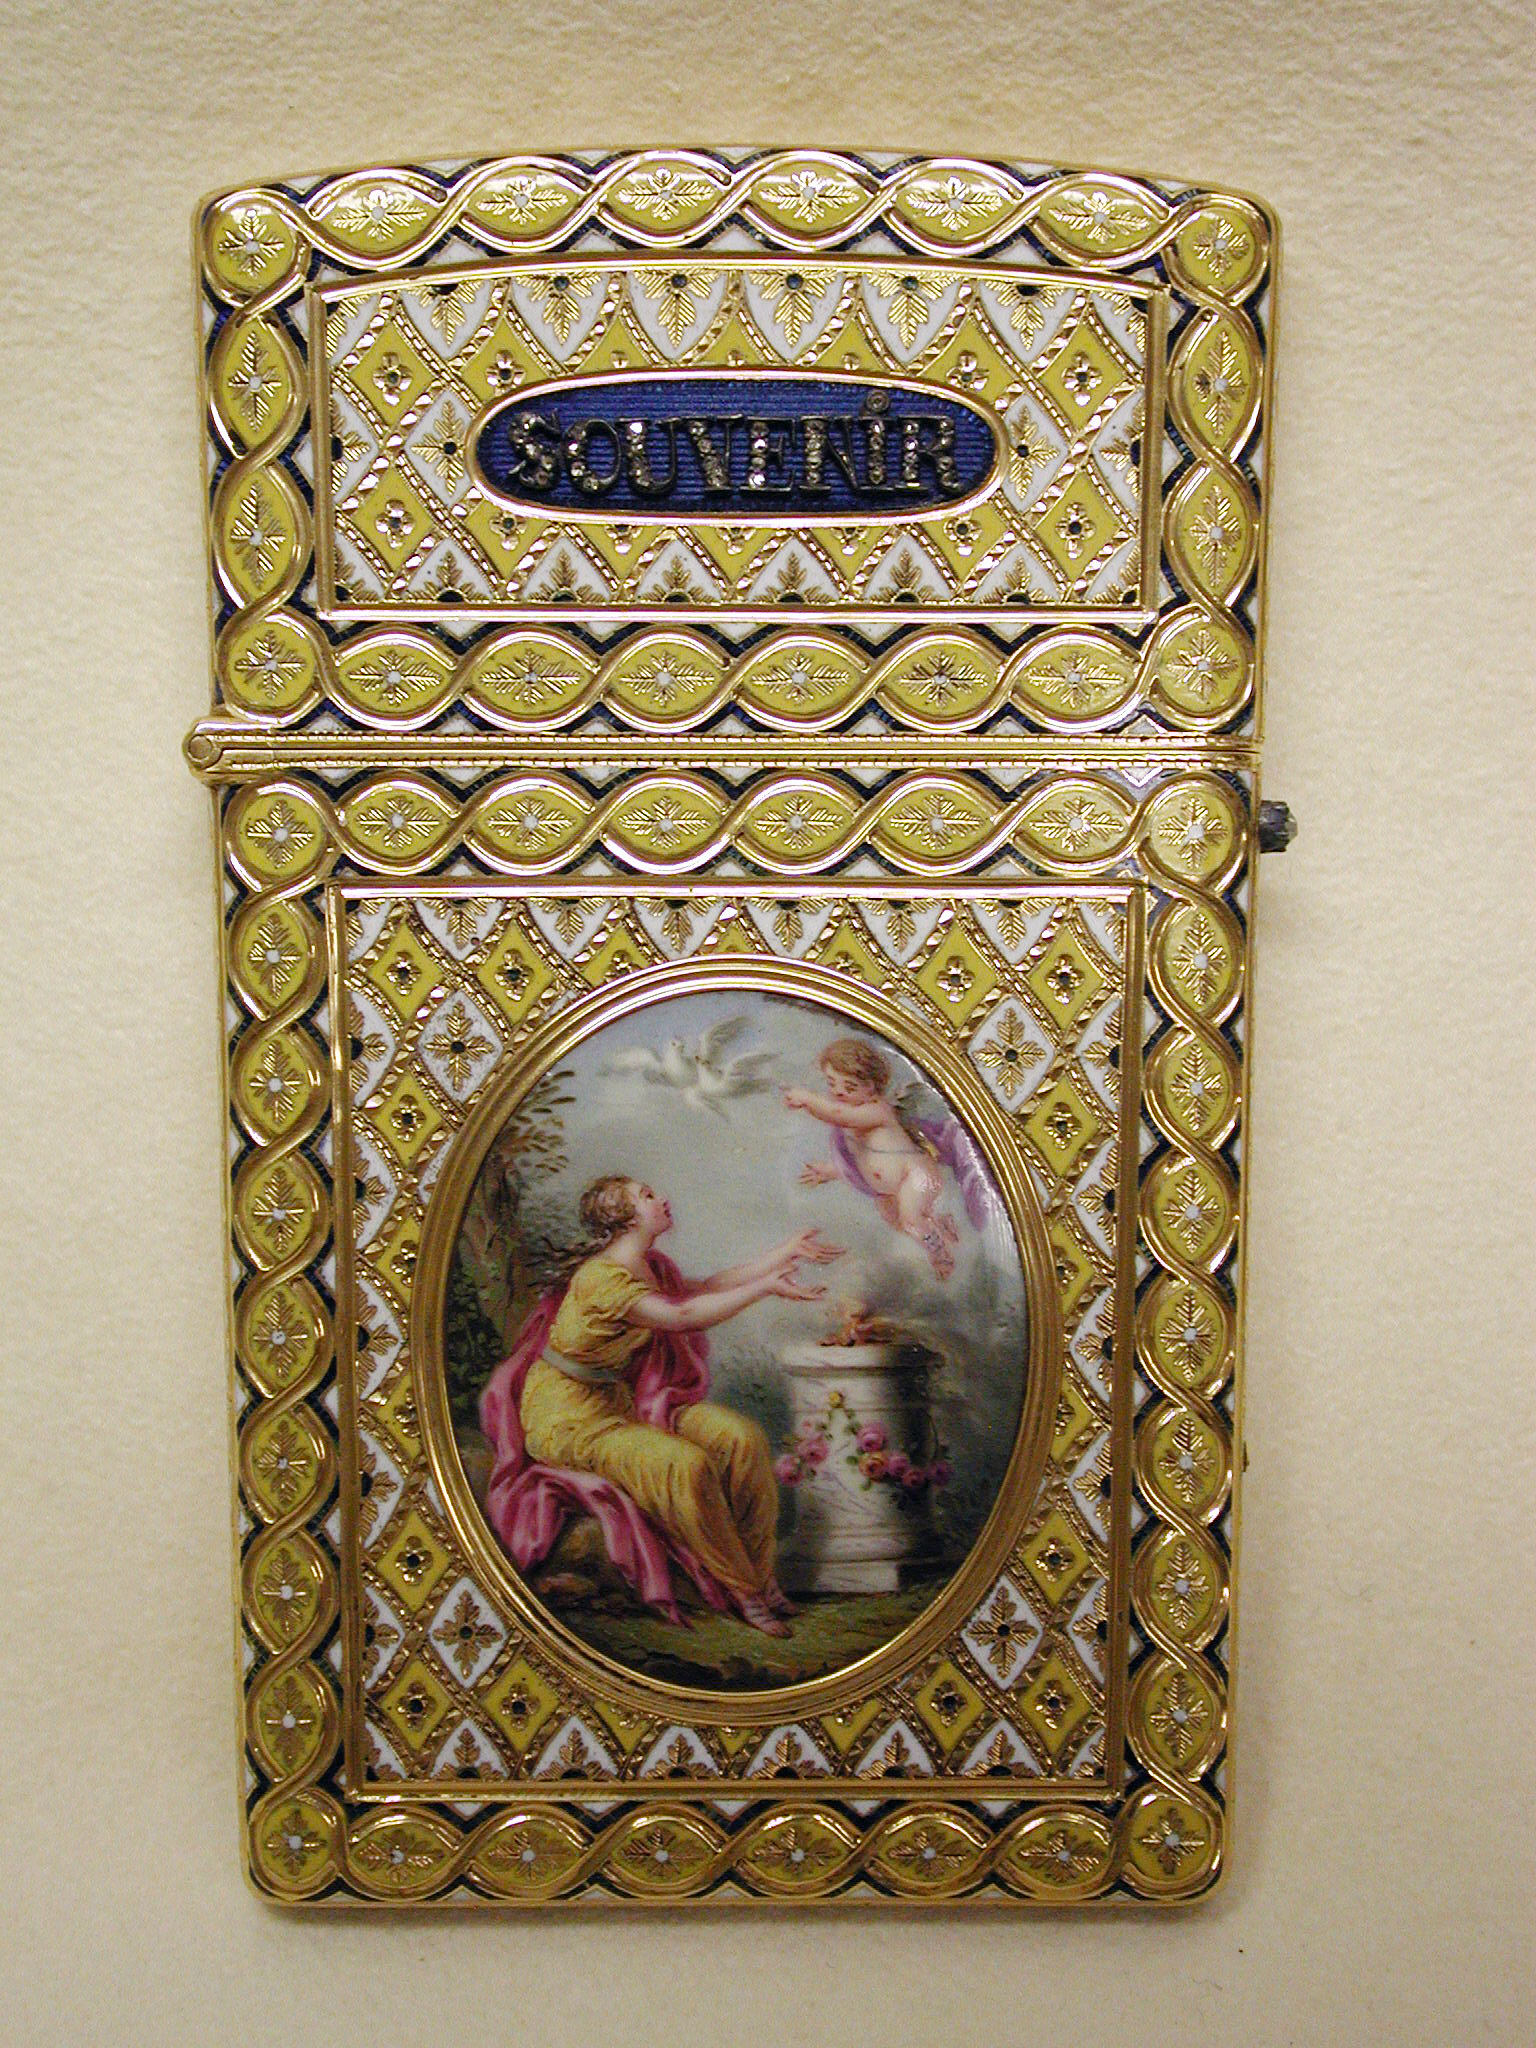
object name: souvenir, painting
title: Souvenir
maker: gabriel lebidois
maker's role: maker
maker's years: 1751-1792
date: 1782-1783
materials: diamond, enamel, gold, ivory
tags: birds,women,putti